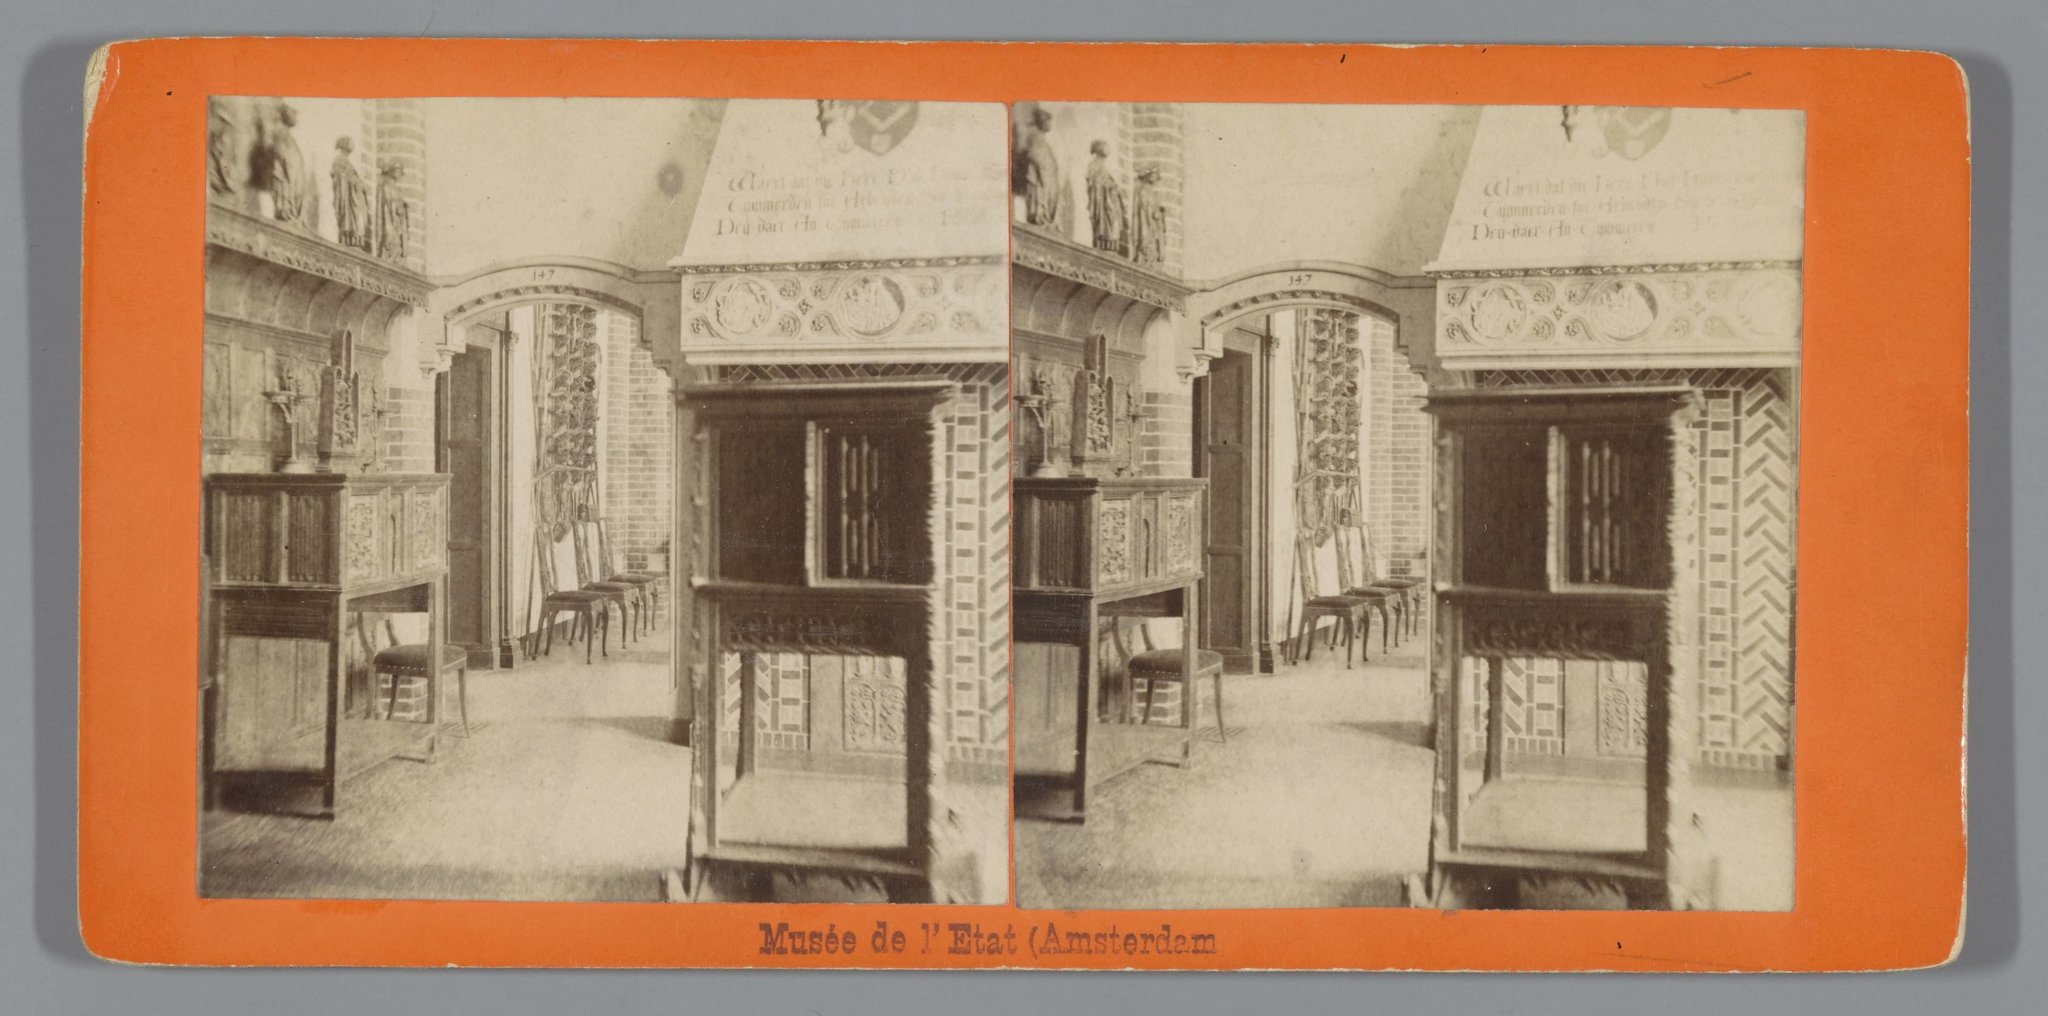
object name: stereograph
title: Zaal 147, gewijd aan de Middeleeuwen, in het Rijksmuseum, Amsterdam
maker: andreas theodorus rooswinkel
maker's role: fotograaf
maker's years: 1838-1909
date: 1885-1909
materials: cardboard, paper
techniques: albumen print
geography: amsterdam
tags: permanent exhibition, museum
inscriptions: inscription: ‘No 10/ [...]’